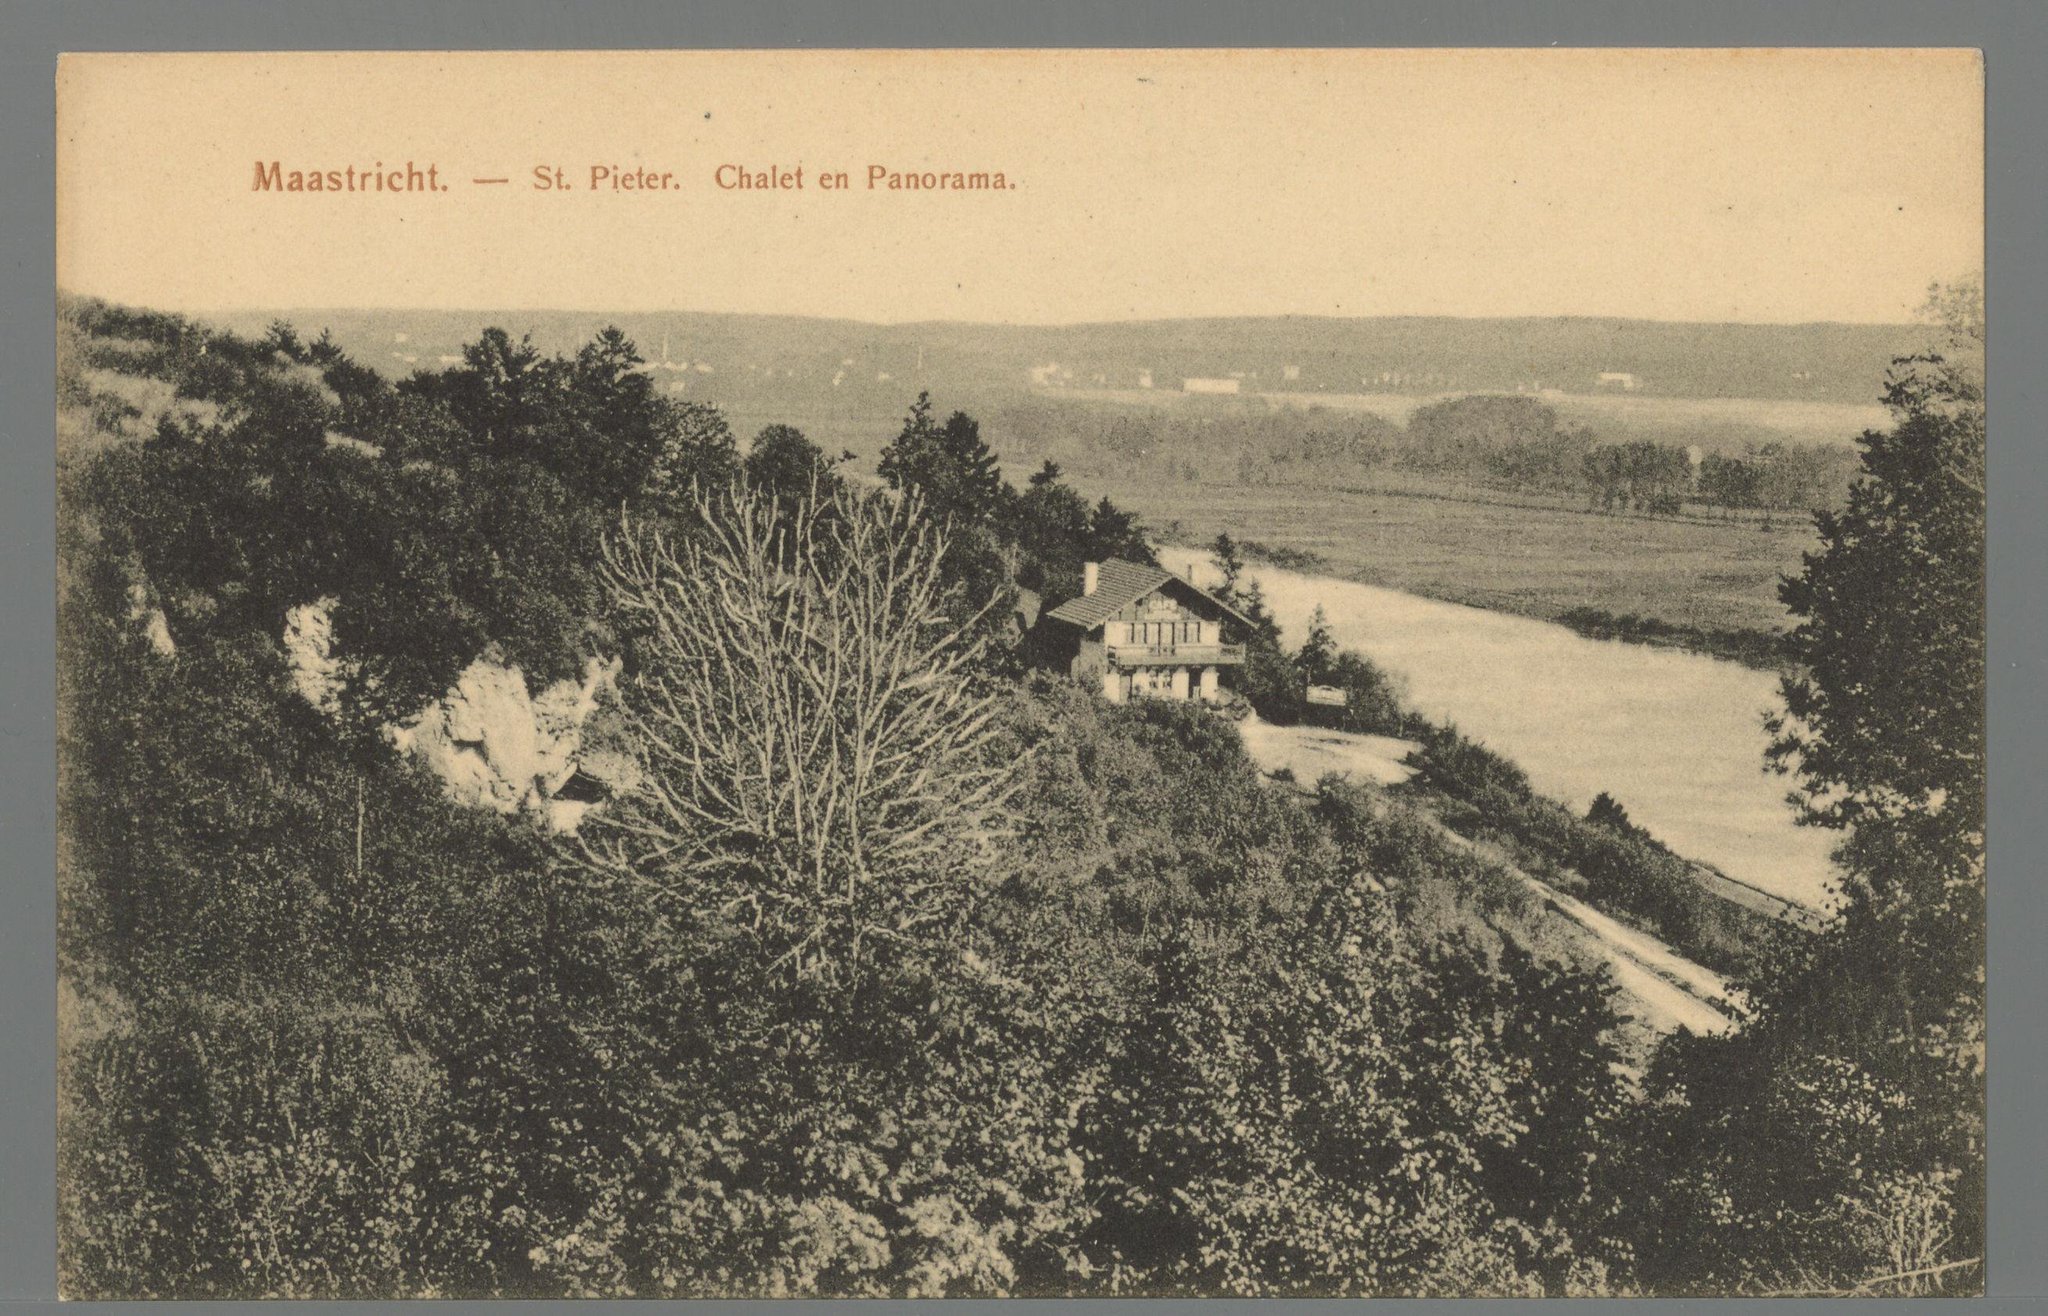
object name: photomechanical print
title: Maastricht. - St. Pieter. Chalet en panorama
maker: Anonymous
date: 1905-1930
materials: cardboard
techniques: photograph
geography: maastricht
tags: river, cottage, mountains